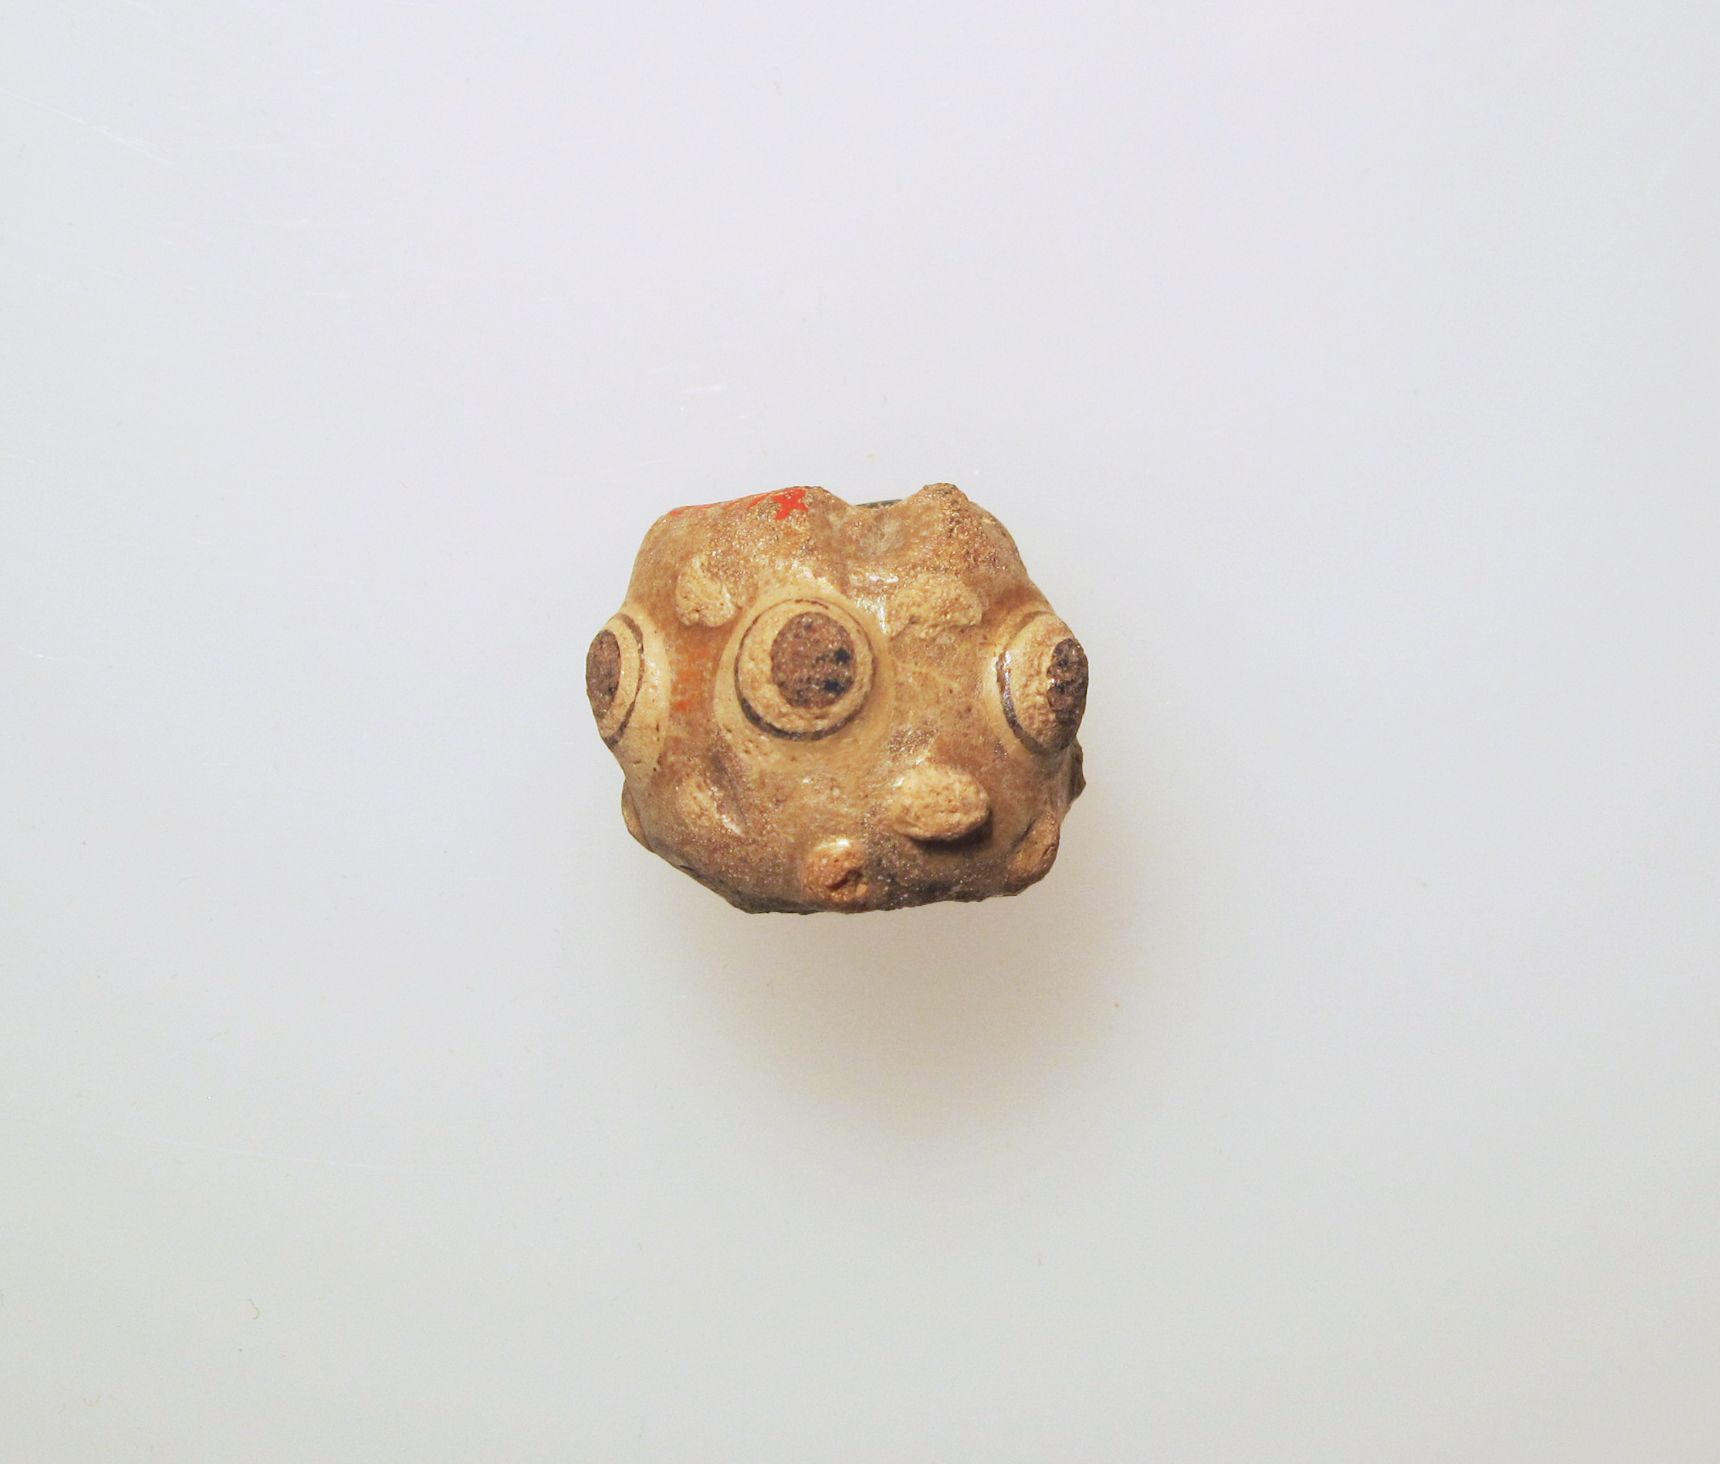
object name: bead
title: Glass eye bead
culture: carthaginian or phoenician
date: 400-201 BCE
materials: glass